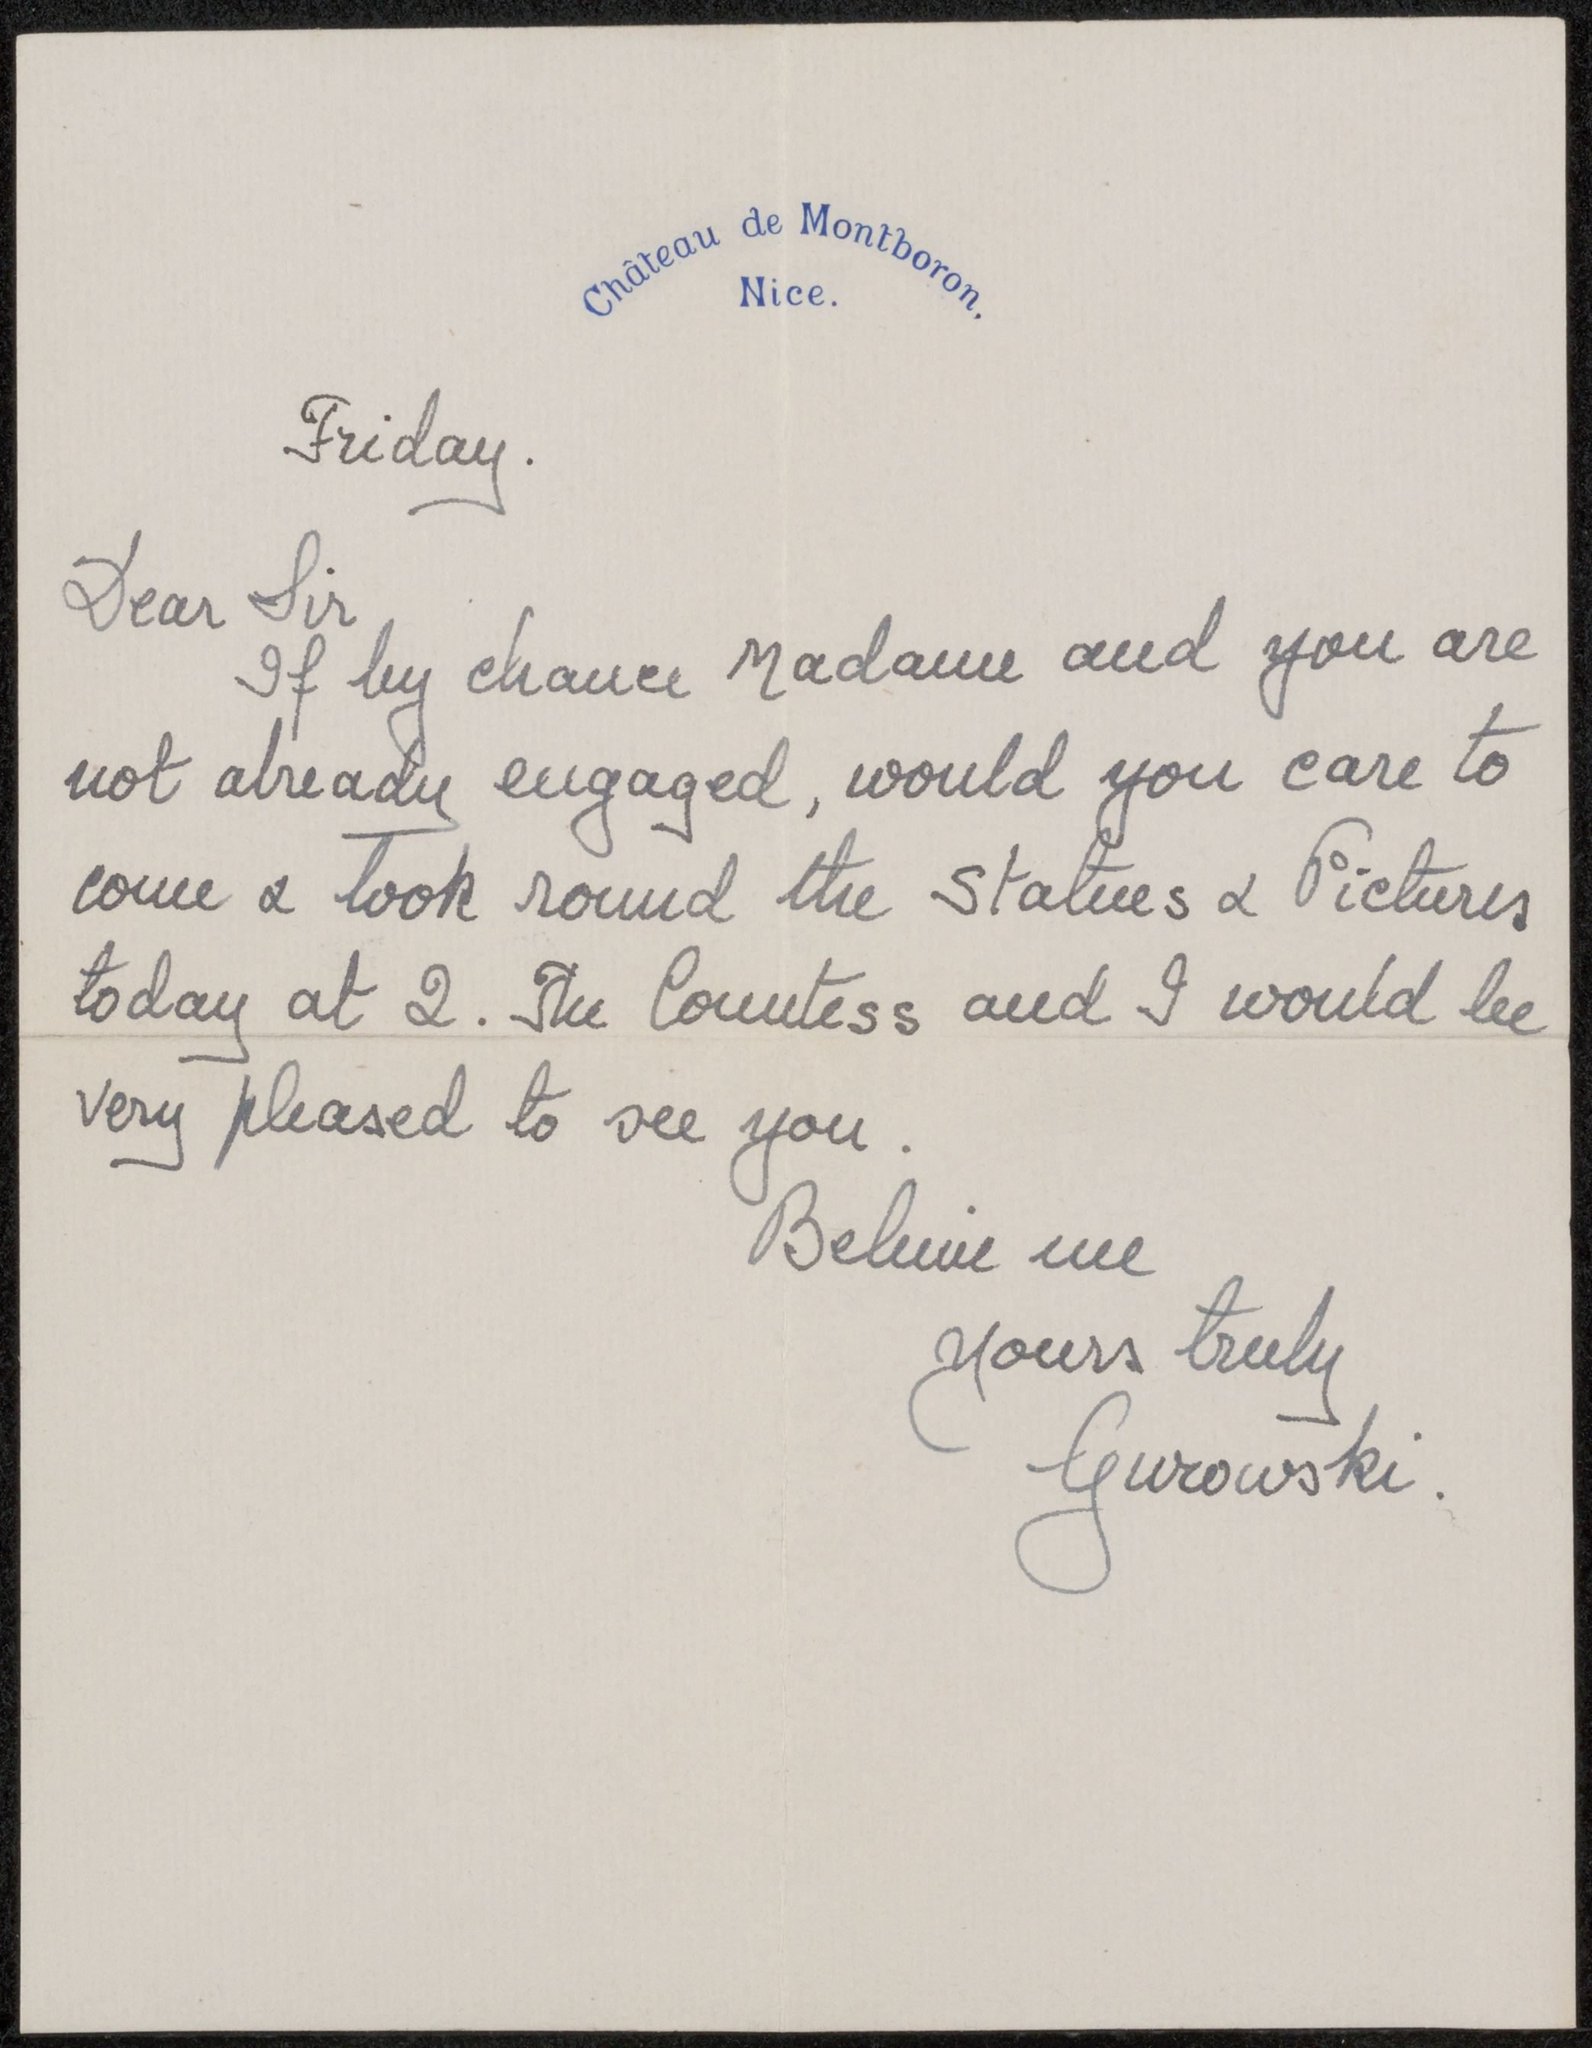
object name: letter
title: Brief aan Philip Zilcken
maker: ch. gurowski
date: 1867-1930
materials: ink, paper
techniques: pen, printing, writing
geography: nice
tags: the hague, painter, draughtsman, philip zilcken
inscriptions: address: ‘Château de Montboron,/ Nice.’, collector's mark: ‘RPK’